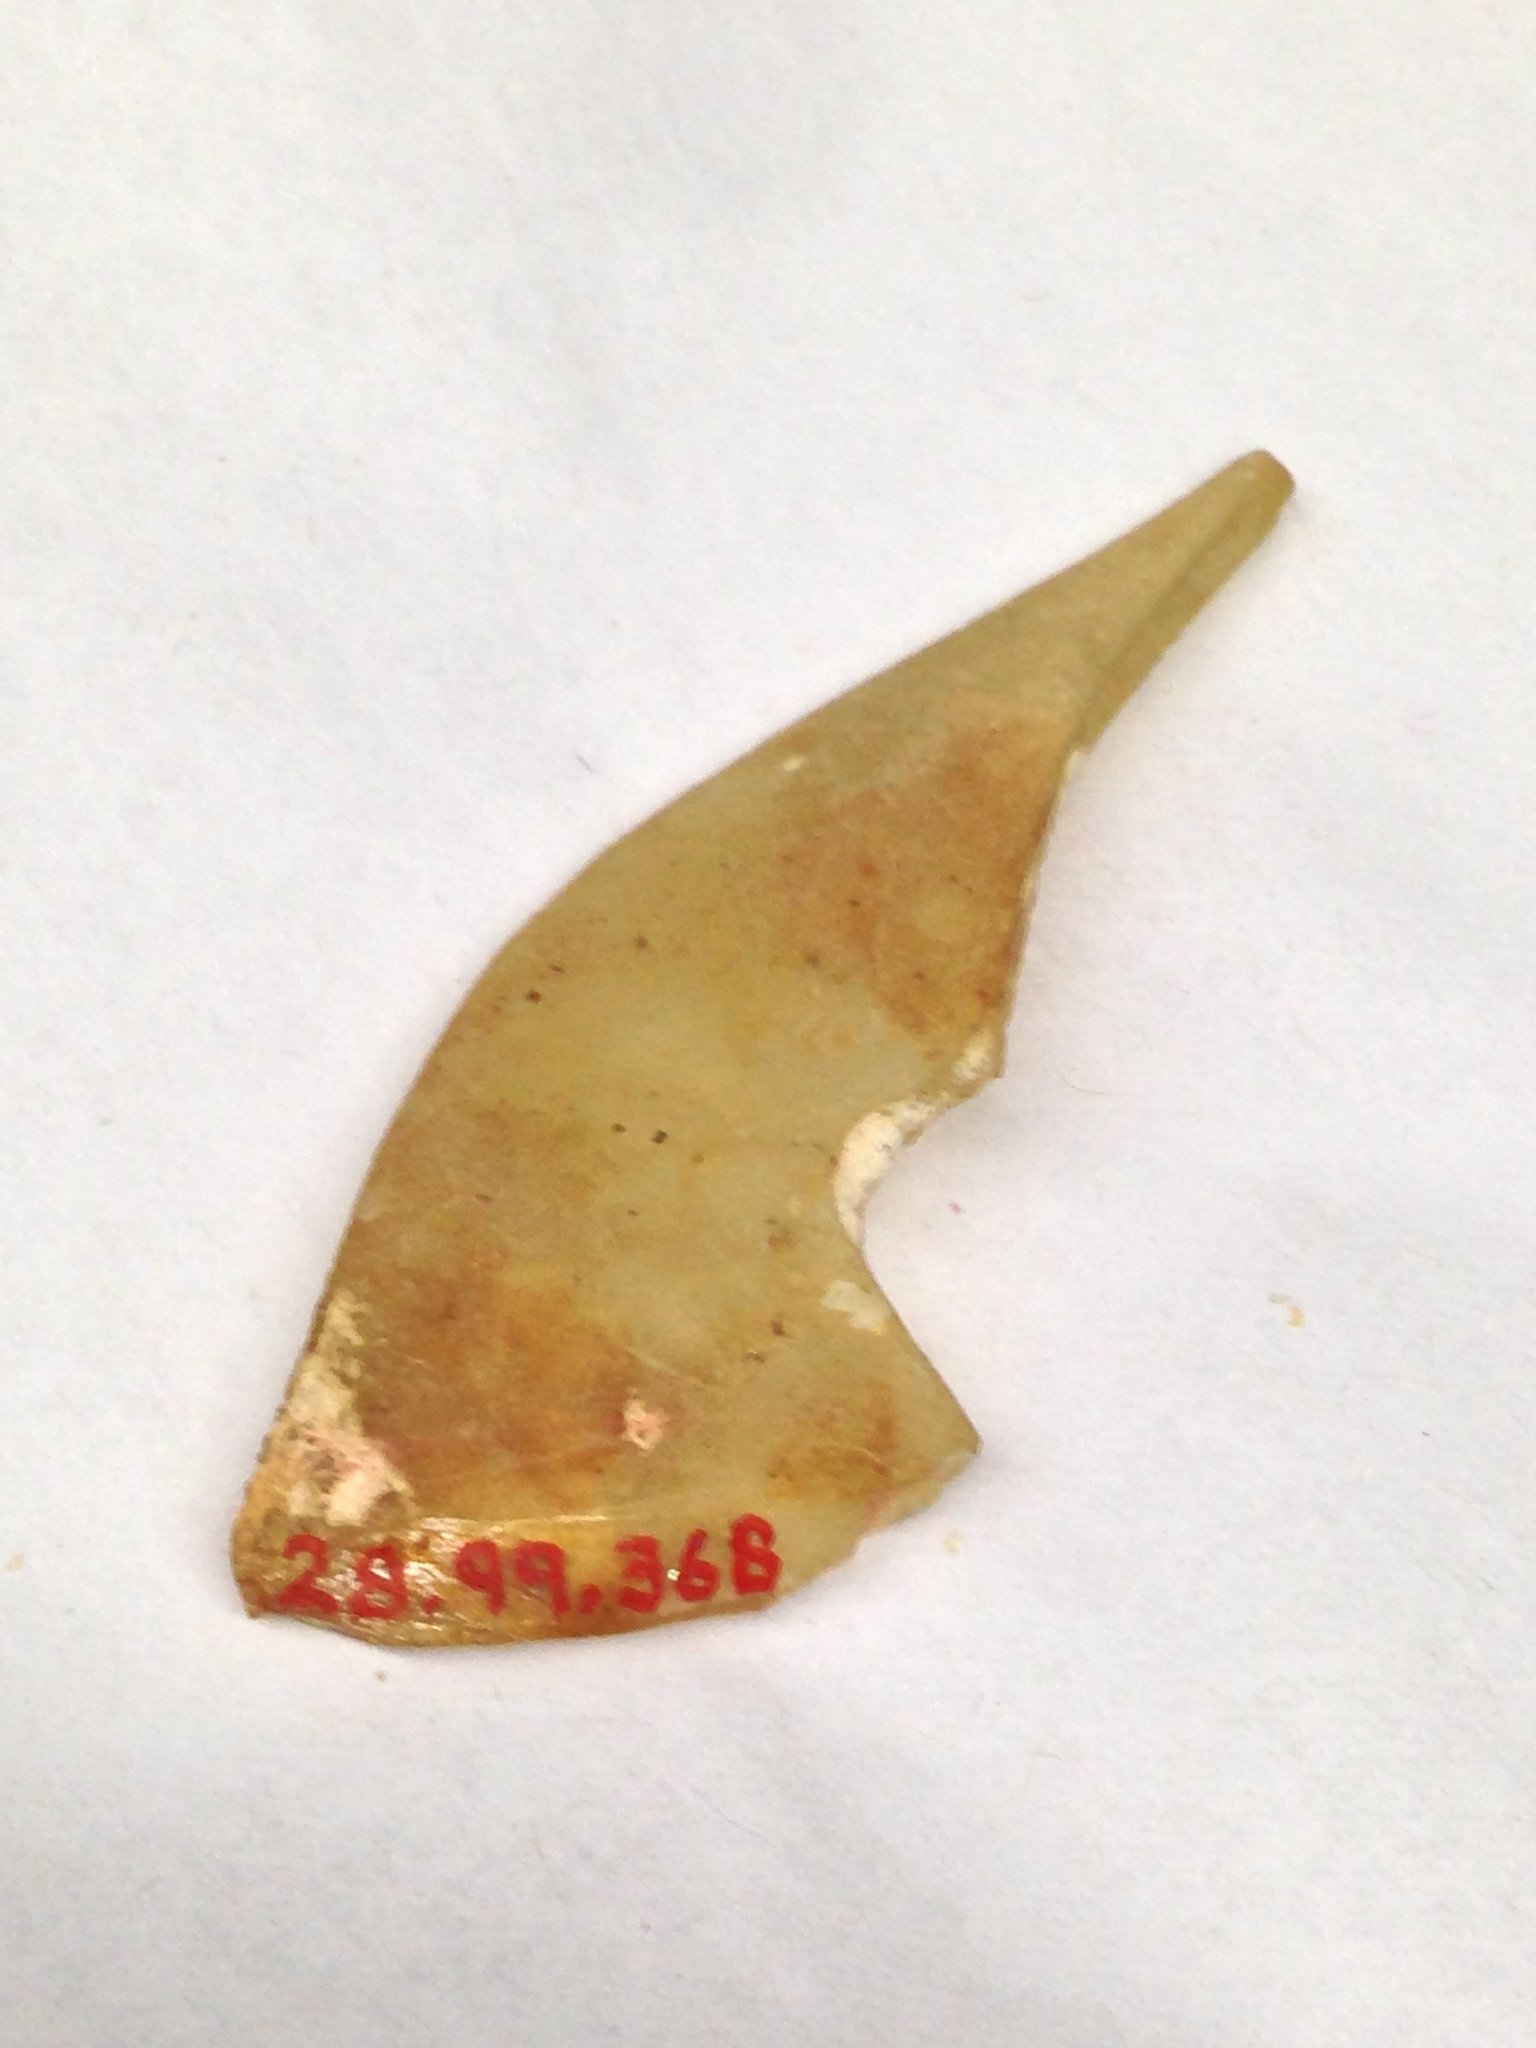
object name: fragment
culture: european or middle eastern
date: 1150-1250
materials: ceramic, glass